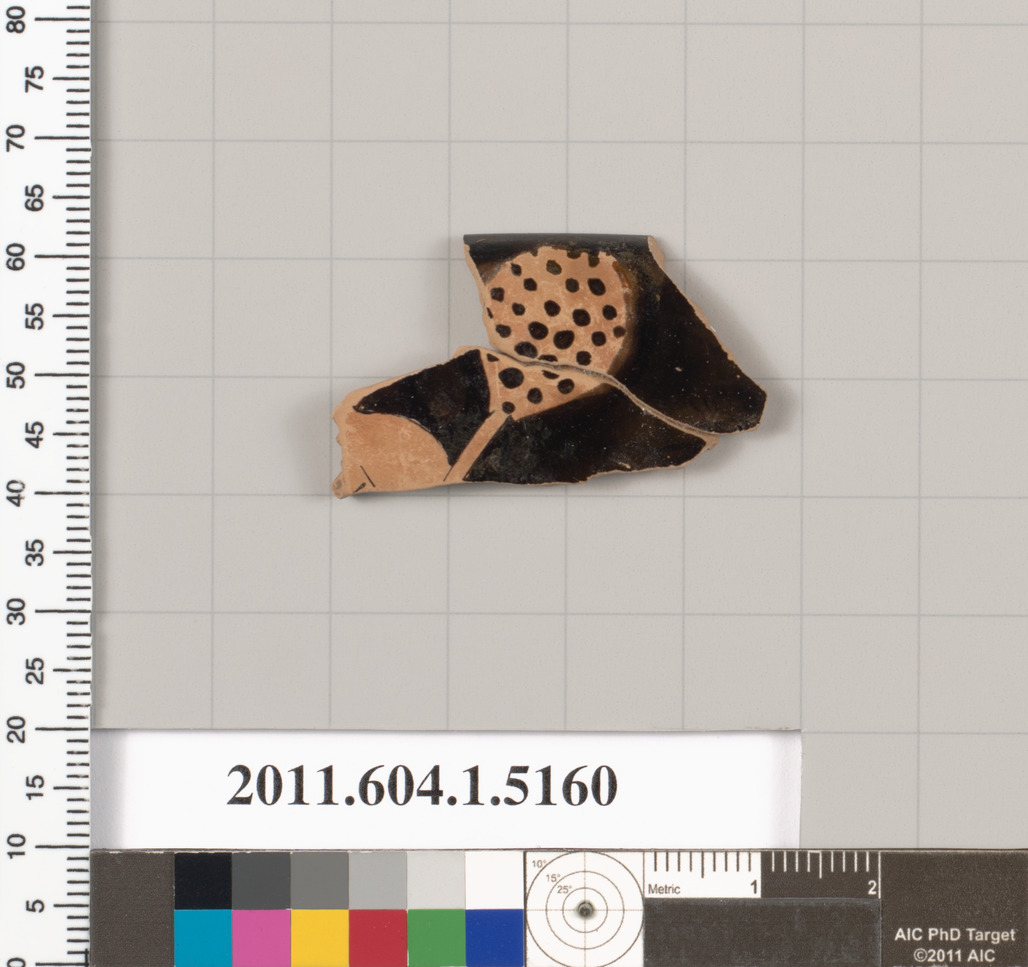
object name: kylix fragment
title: Terracotta rim fragment of a kylix (drinking cup)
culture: greek, attic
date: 475-451 BCE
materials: terracotta